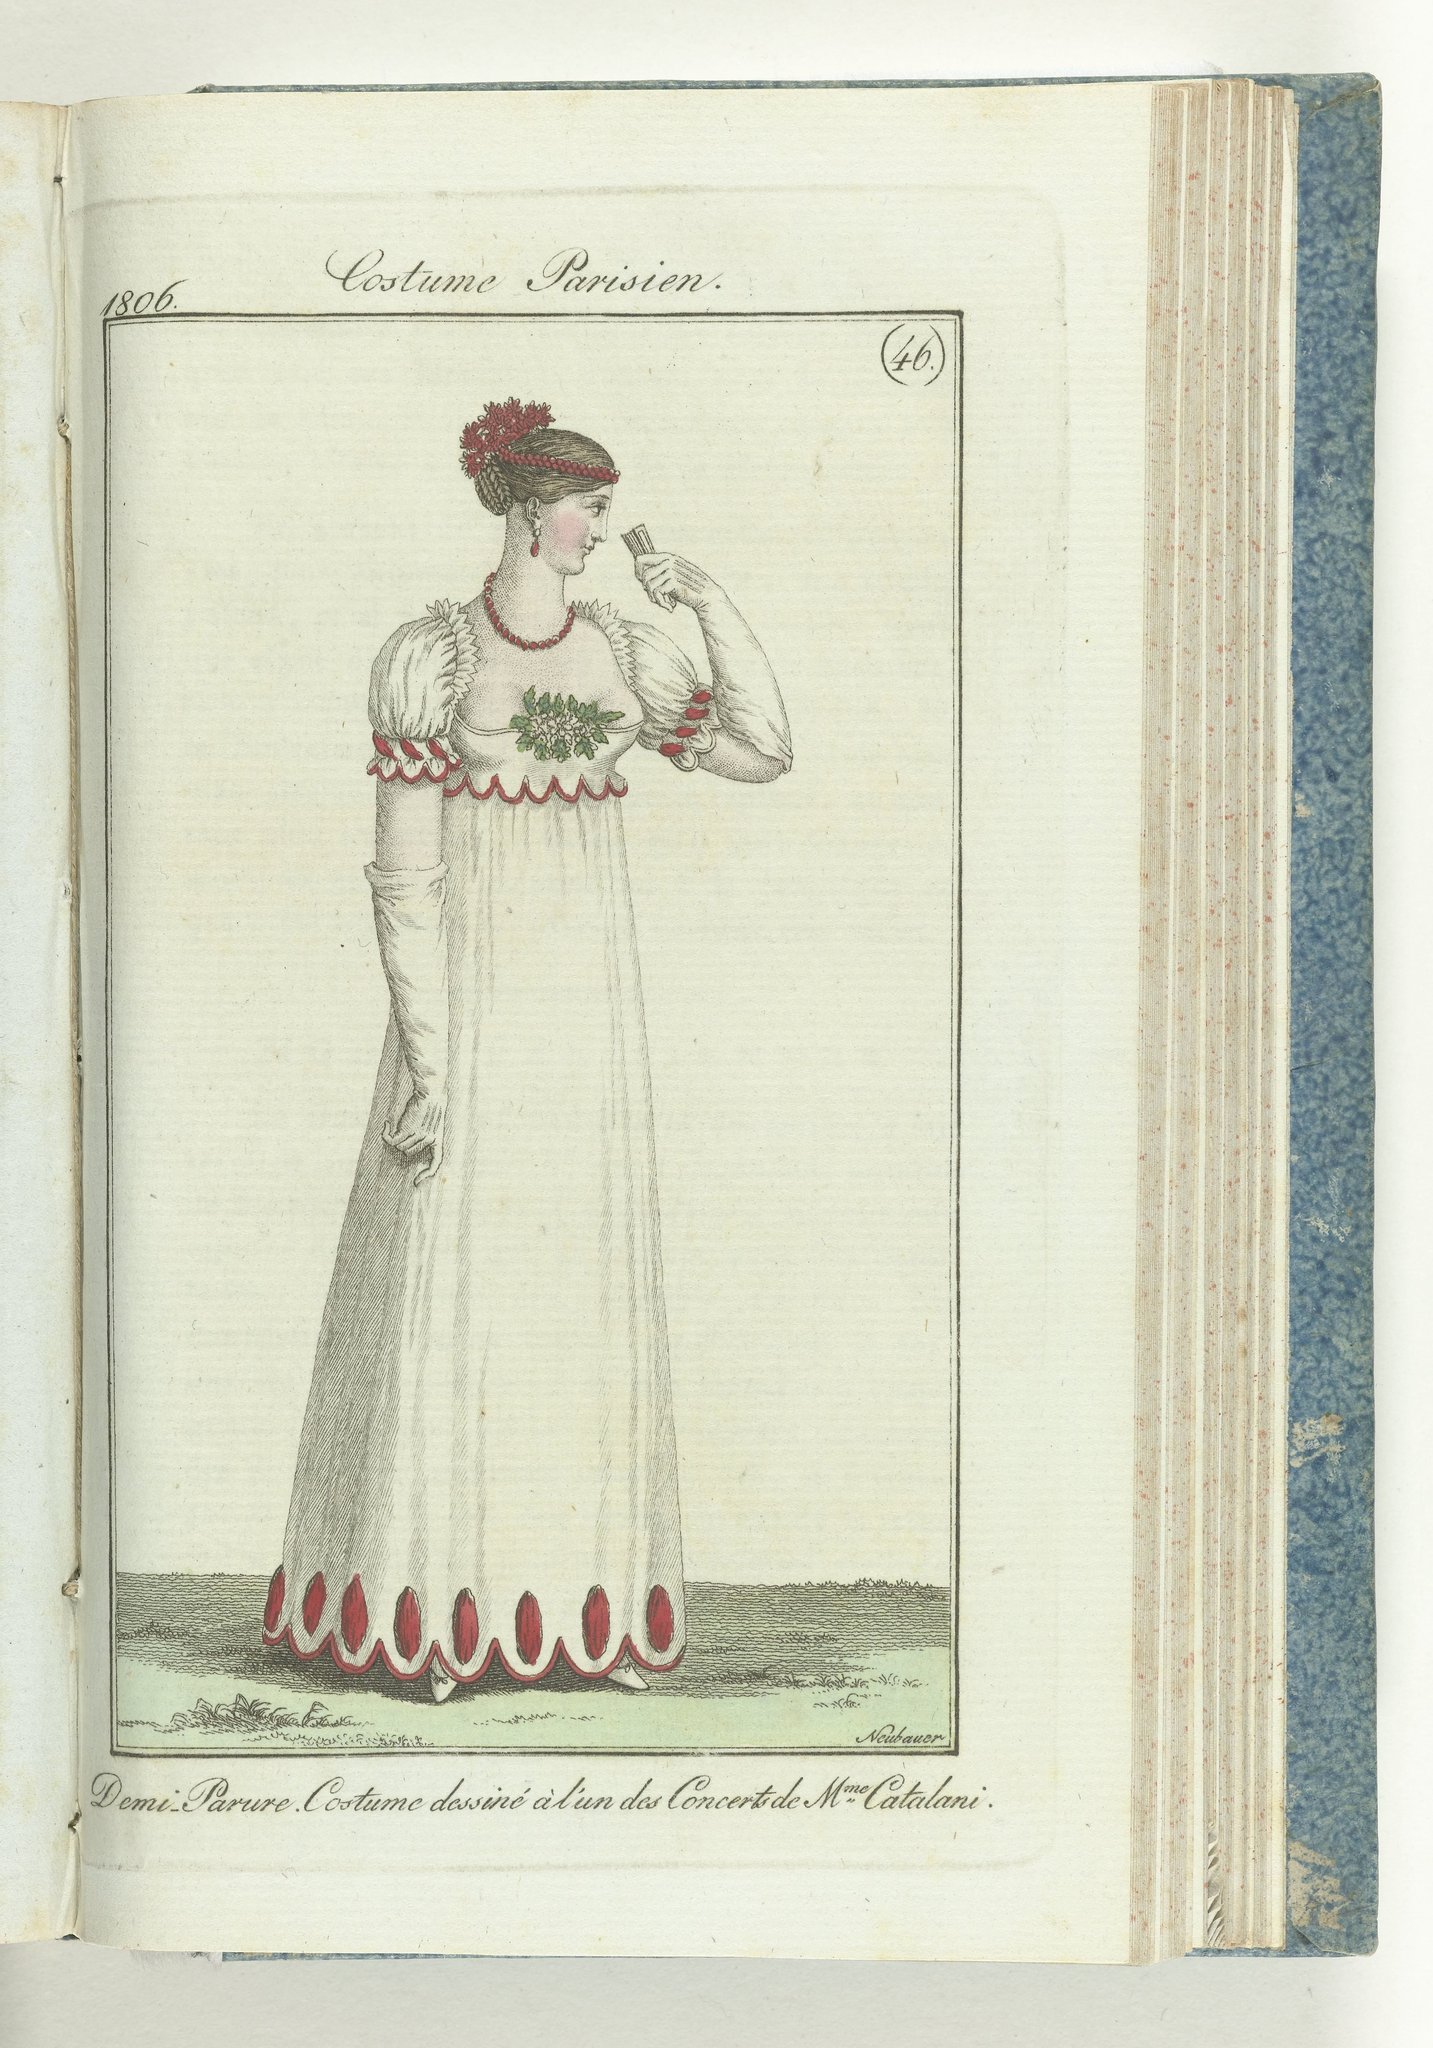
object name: magazine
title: Journal des Dames et des Modes, editie Frankfurt 10 novembre 1806, Costume Parisien (46) : Demi-Parure. Costumne dessiné à l'un des Concerts de Mme Catalani.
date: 1806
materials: paper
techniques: engraving, hand coloring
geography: frankfurt am main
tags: ear-rings (+ women's clothes), gloves, mittens (long gloves) (+ women's clothes), styles of hairdress - aa - ~ women, fashion plates, shoes, sandals (+ women's clothes), dress, gown (+ women's clothes), necklace (+ women's clothes)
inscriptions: caption: ‘Demi-Parure. Costume dessiné à l'un des Concerts de Mme Catalani’, title: ‘Costume Parisien.’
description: Volgens het onderschrift is de 'Demi Parure' getekend tijdens een concert van madame Catalani. De begeleidende tekst (p. 182) meldt: Kapsel met strak achterover gekamd haar en vlechten, versierd met een tres amaranthes en een toef in dezelfde kleur op het achterhoofd. Oorbellen en ketting van bloedkoraal. Japon van witte mousseline, met garnering in rood. Korte poffende mouwen. Witte (lange) handschoenen en witte schoenen. De prent maakt deel uit van het modetijdschrift Journal des Dames et des Modes, uitgegeven in Frankfurt als kopie van de Franse editie van Pierre de la Mésangère, (1798-1848).